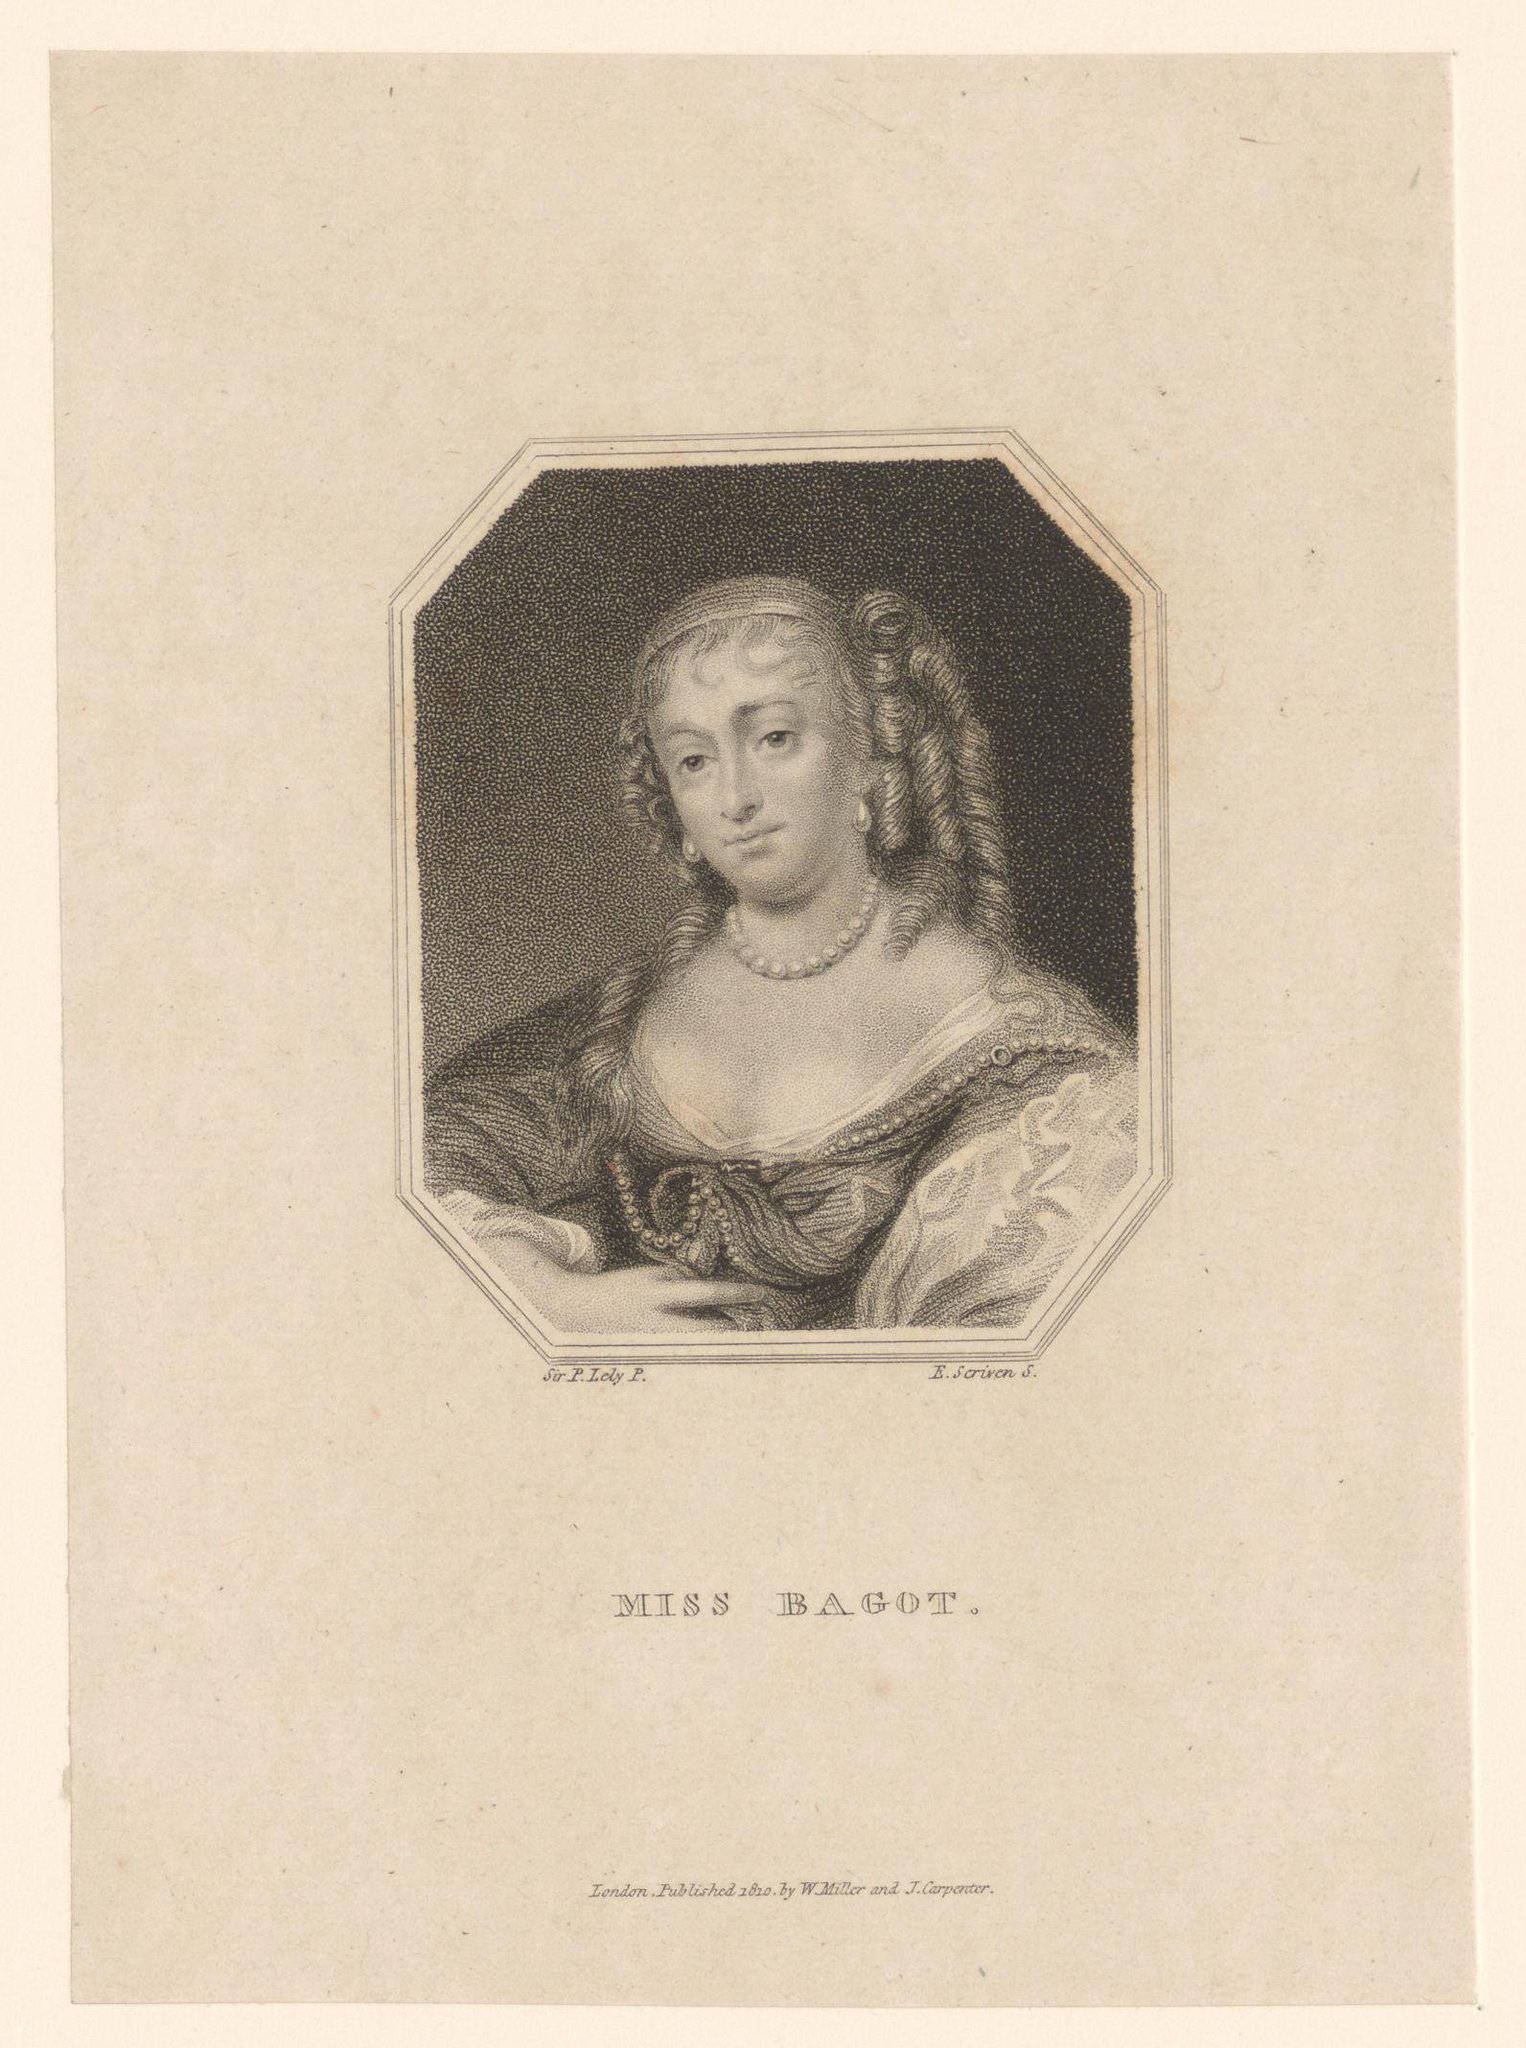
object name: book illustration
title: Portret van Mary Bagot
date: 1810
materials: paper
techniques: etching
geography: london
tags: historical persons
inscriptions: collector's mark: Lugt 2228, collector's mark: Lugt 2228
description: Prent gebruikt in: Hamilton, Anthony. Memoirs of Count Grammont. Londen: Carpenter & Miller, 1811.